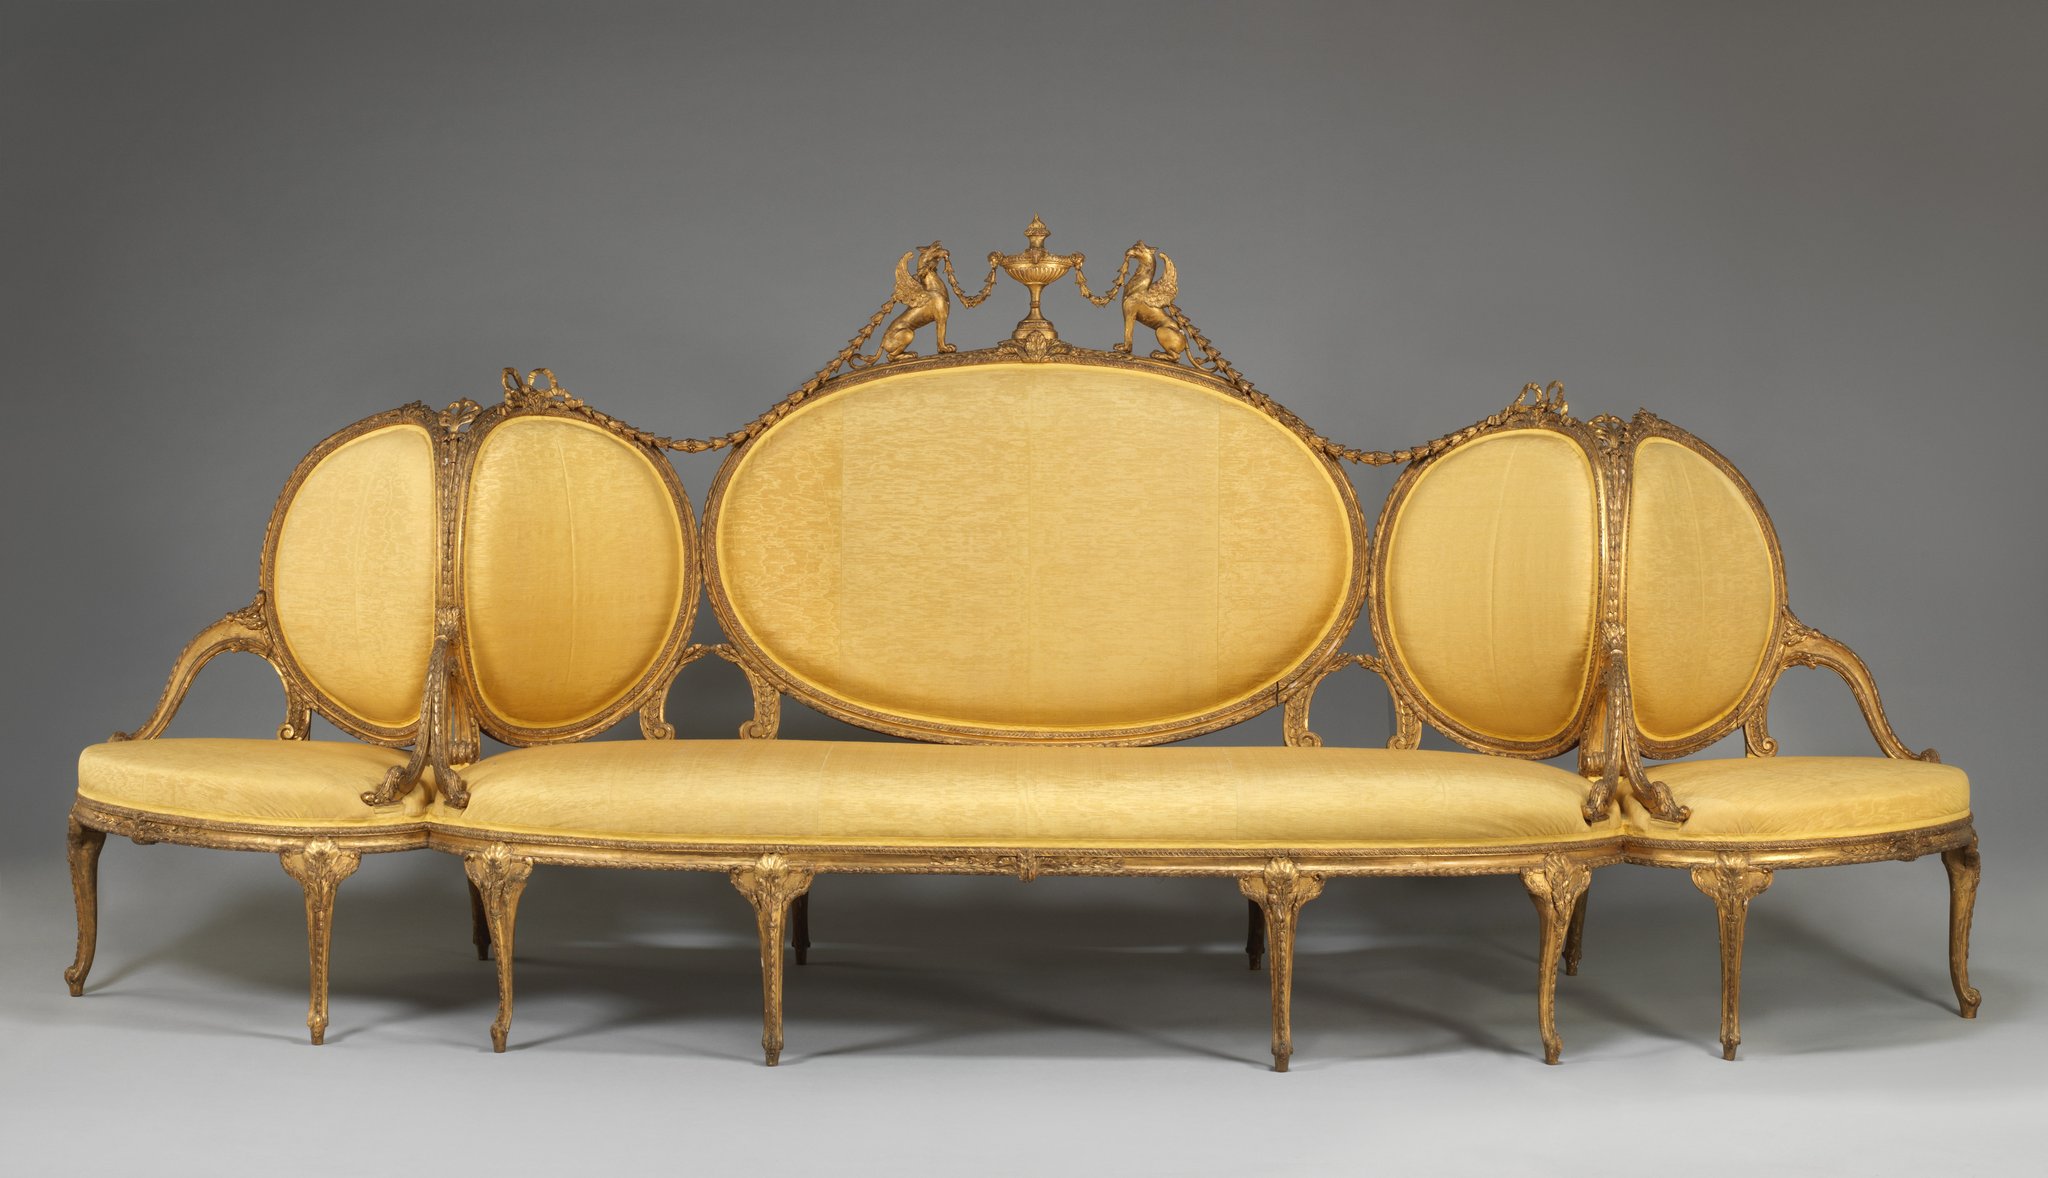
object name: settee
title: Settee (Confidante) (part of a set)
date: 1770-1780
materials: wood, gilt, silk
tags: griffins